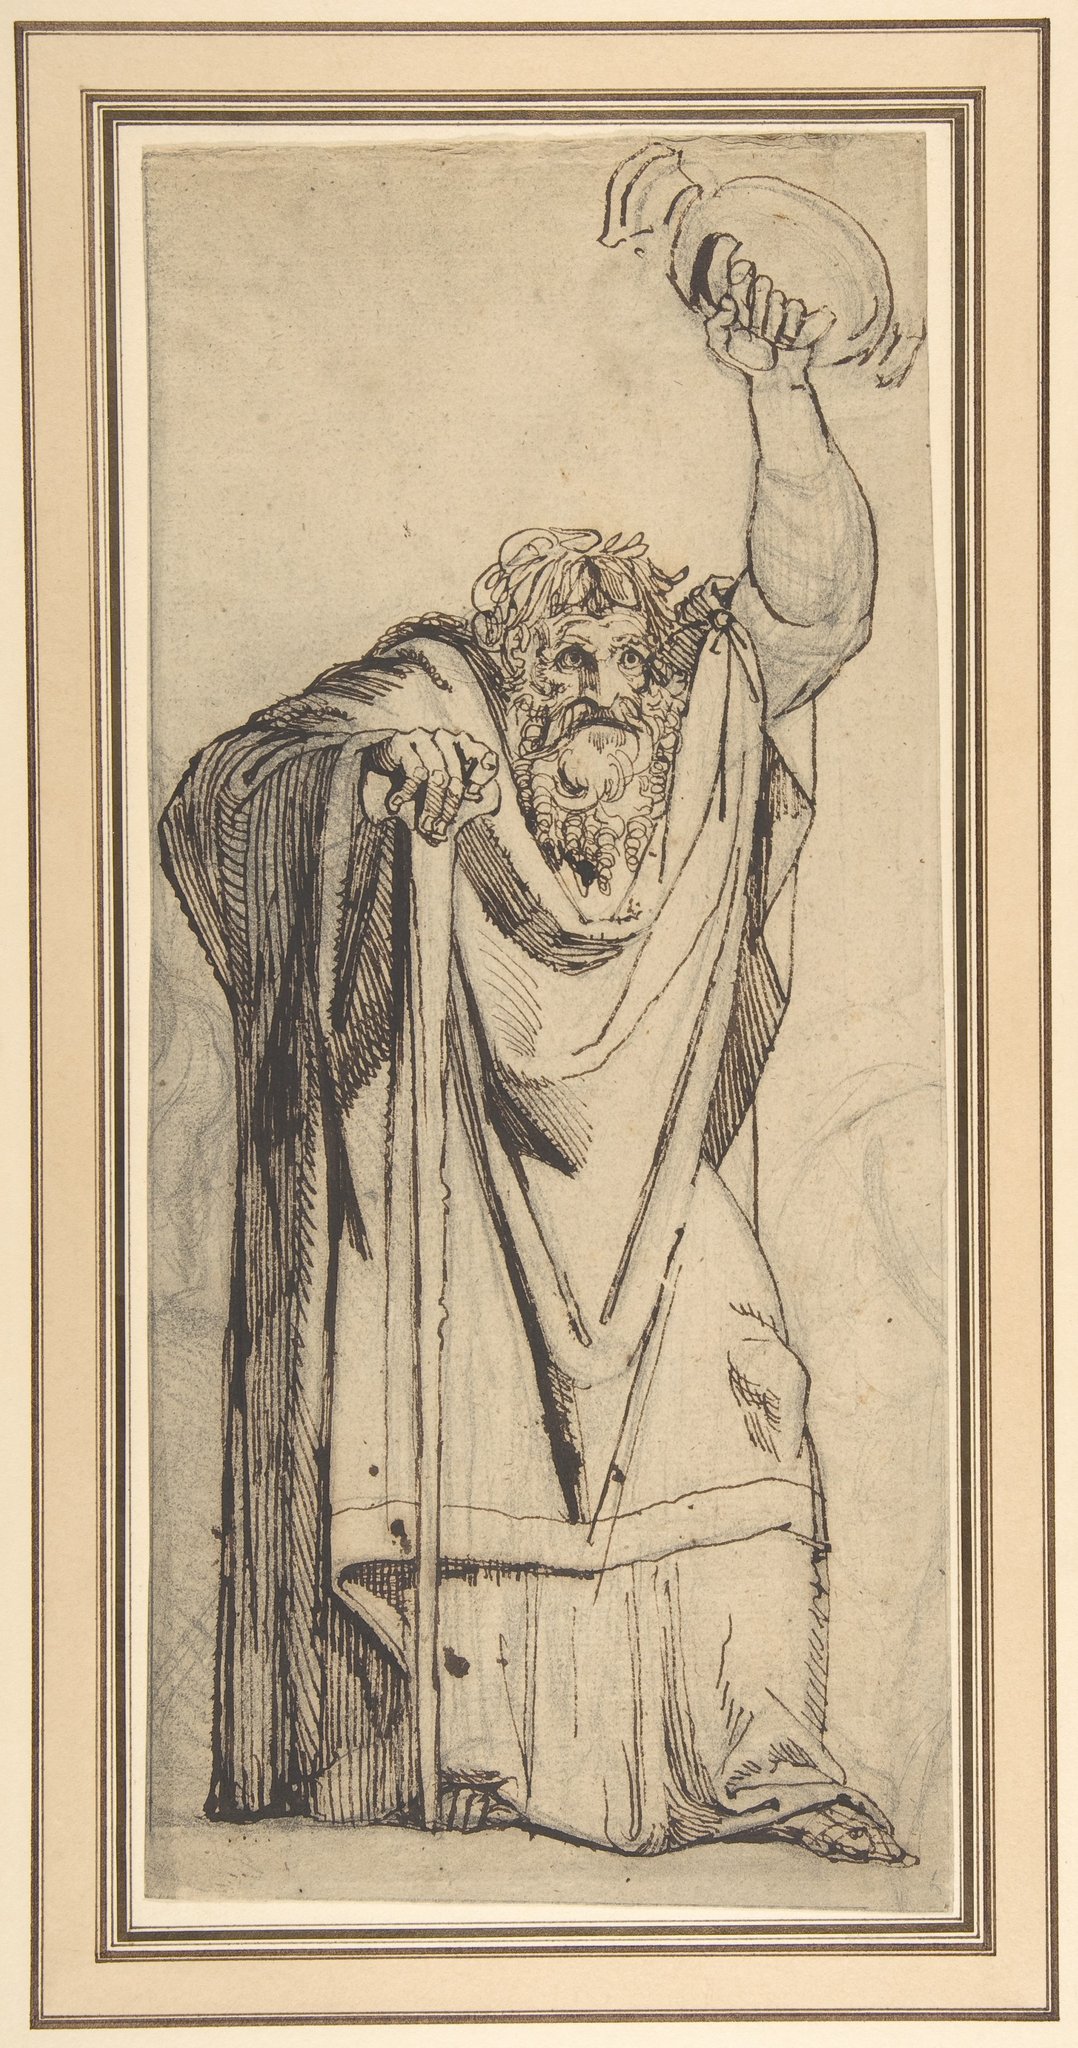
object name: drawing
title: Study for the Prophet Jeremiah (recto); Studies of a Horse Seen from Below and of a Man Seated on a Chair, Probably a Self-Portrait and an Off-Print in Brown Ink of a Nude Female Abdomen and Legs (verso)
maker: henry fuseli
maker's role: artist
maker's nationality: swiss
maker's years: 1741-1825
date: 1764-1770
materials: graphite, ink, paper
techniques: pen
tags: men